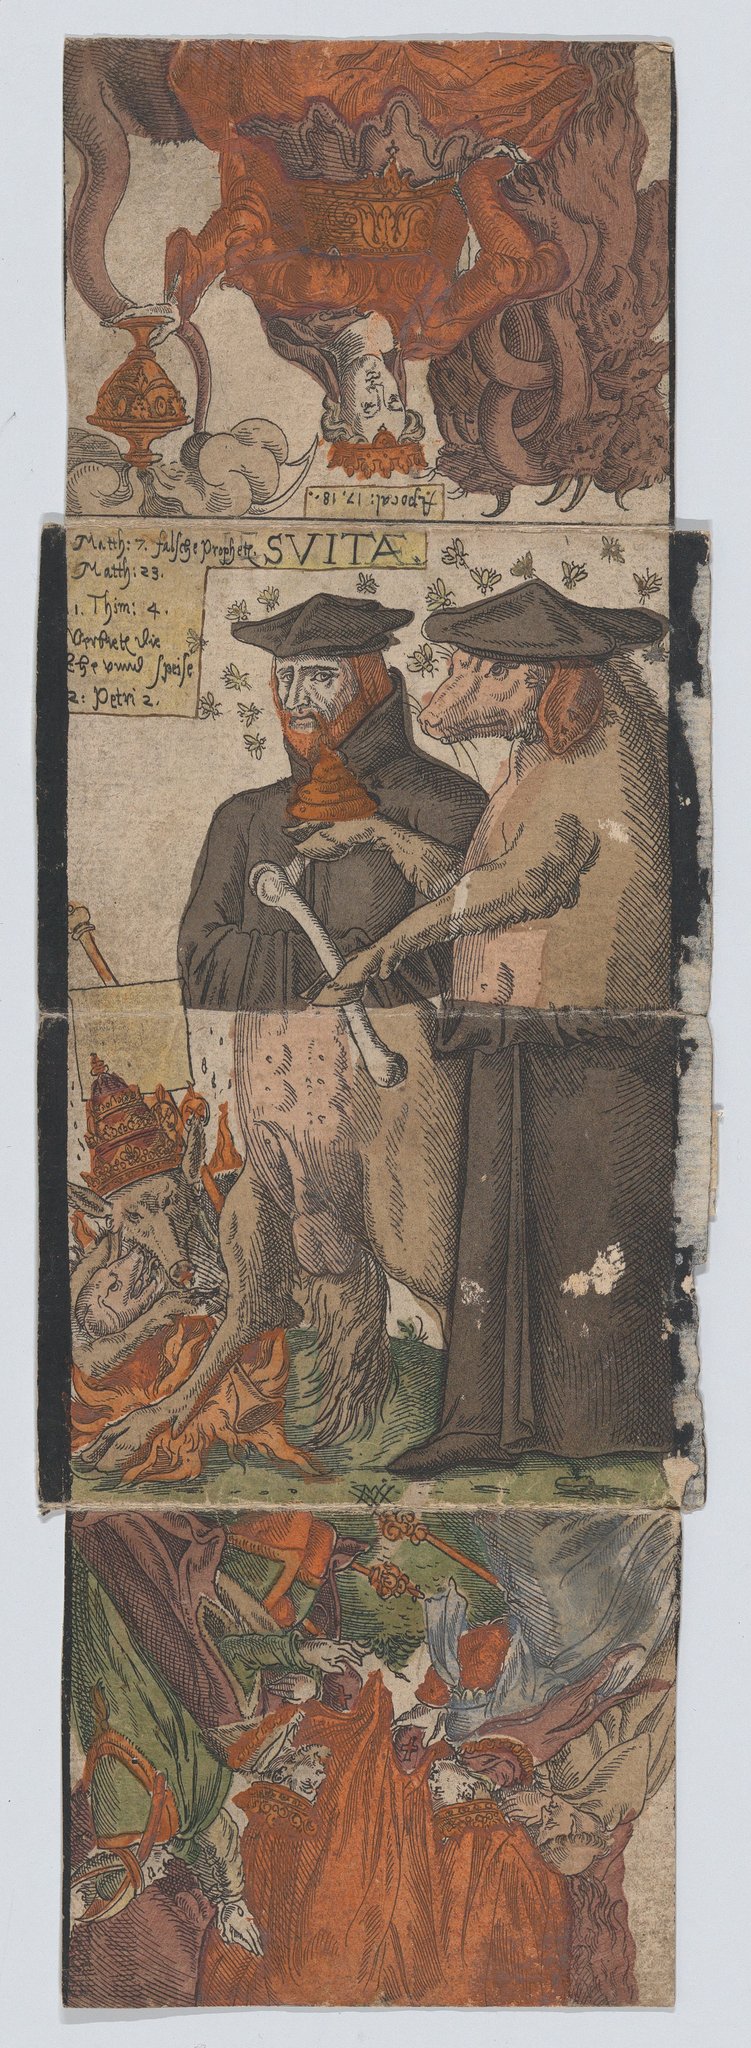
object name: print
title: Metamorphic picture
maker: anonymous, german, 16th century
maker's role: artist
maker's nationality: german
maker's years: 1500-1600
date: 1501-1600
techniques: etching, hand coloring